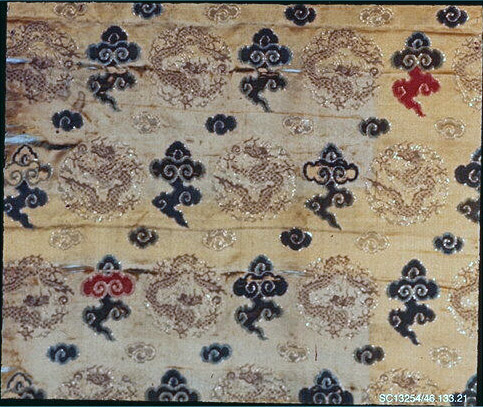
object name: piece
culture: chinese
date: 1601-1700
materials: metal thread, silk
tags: dragons